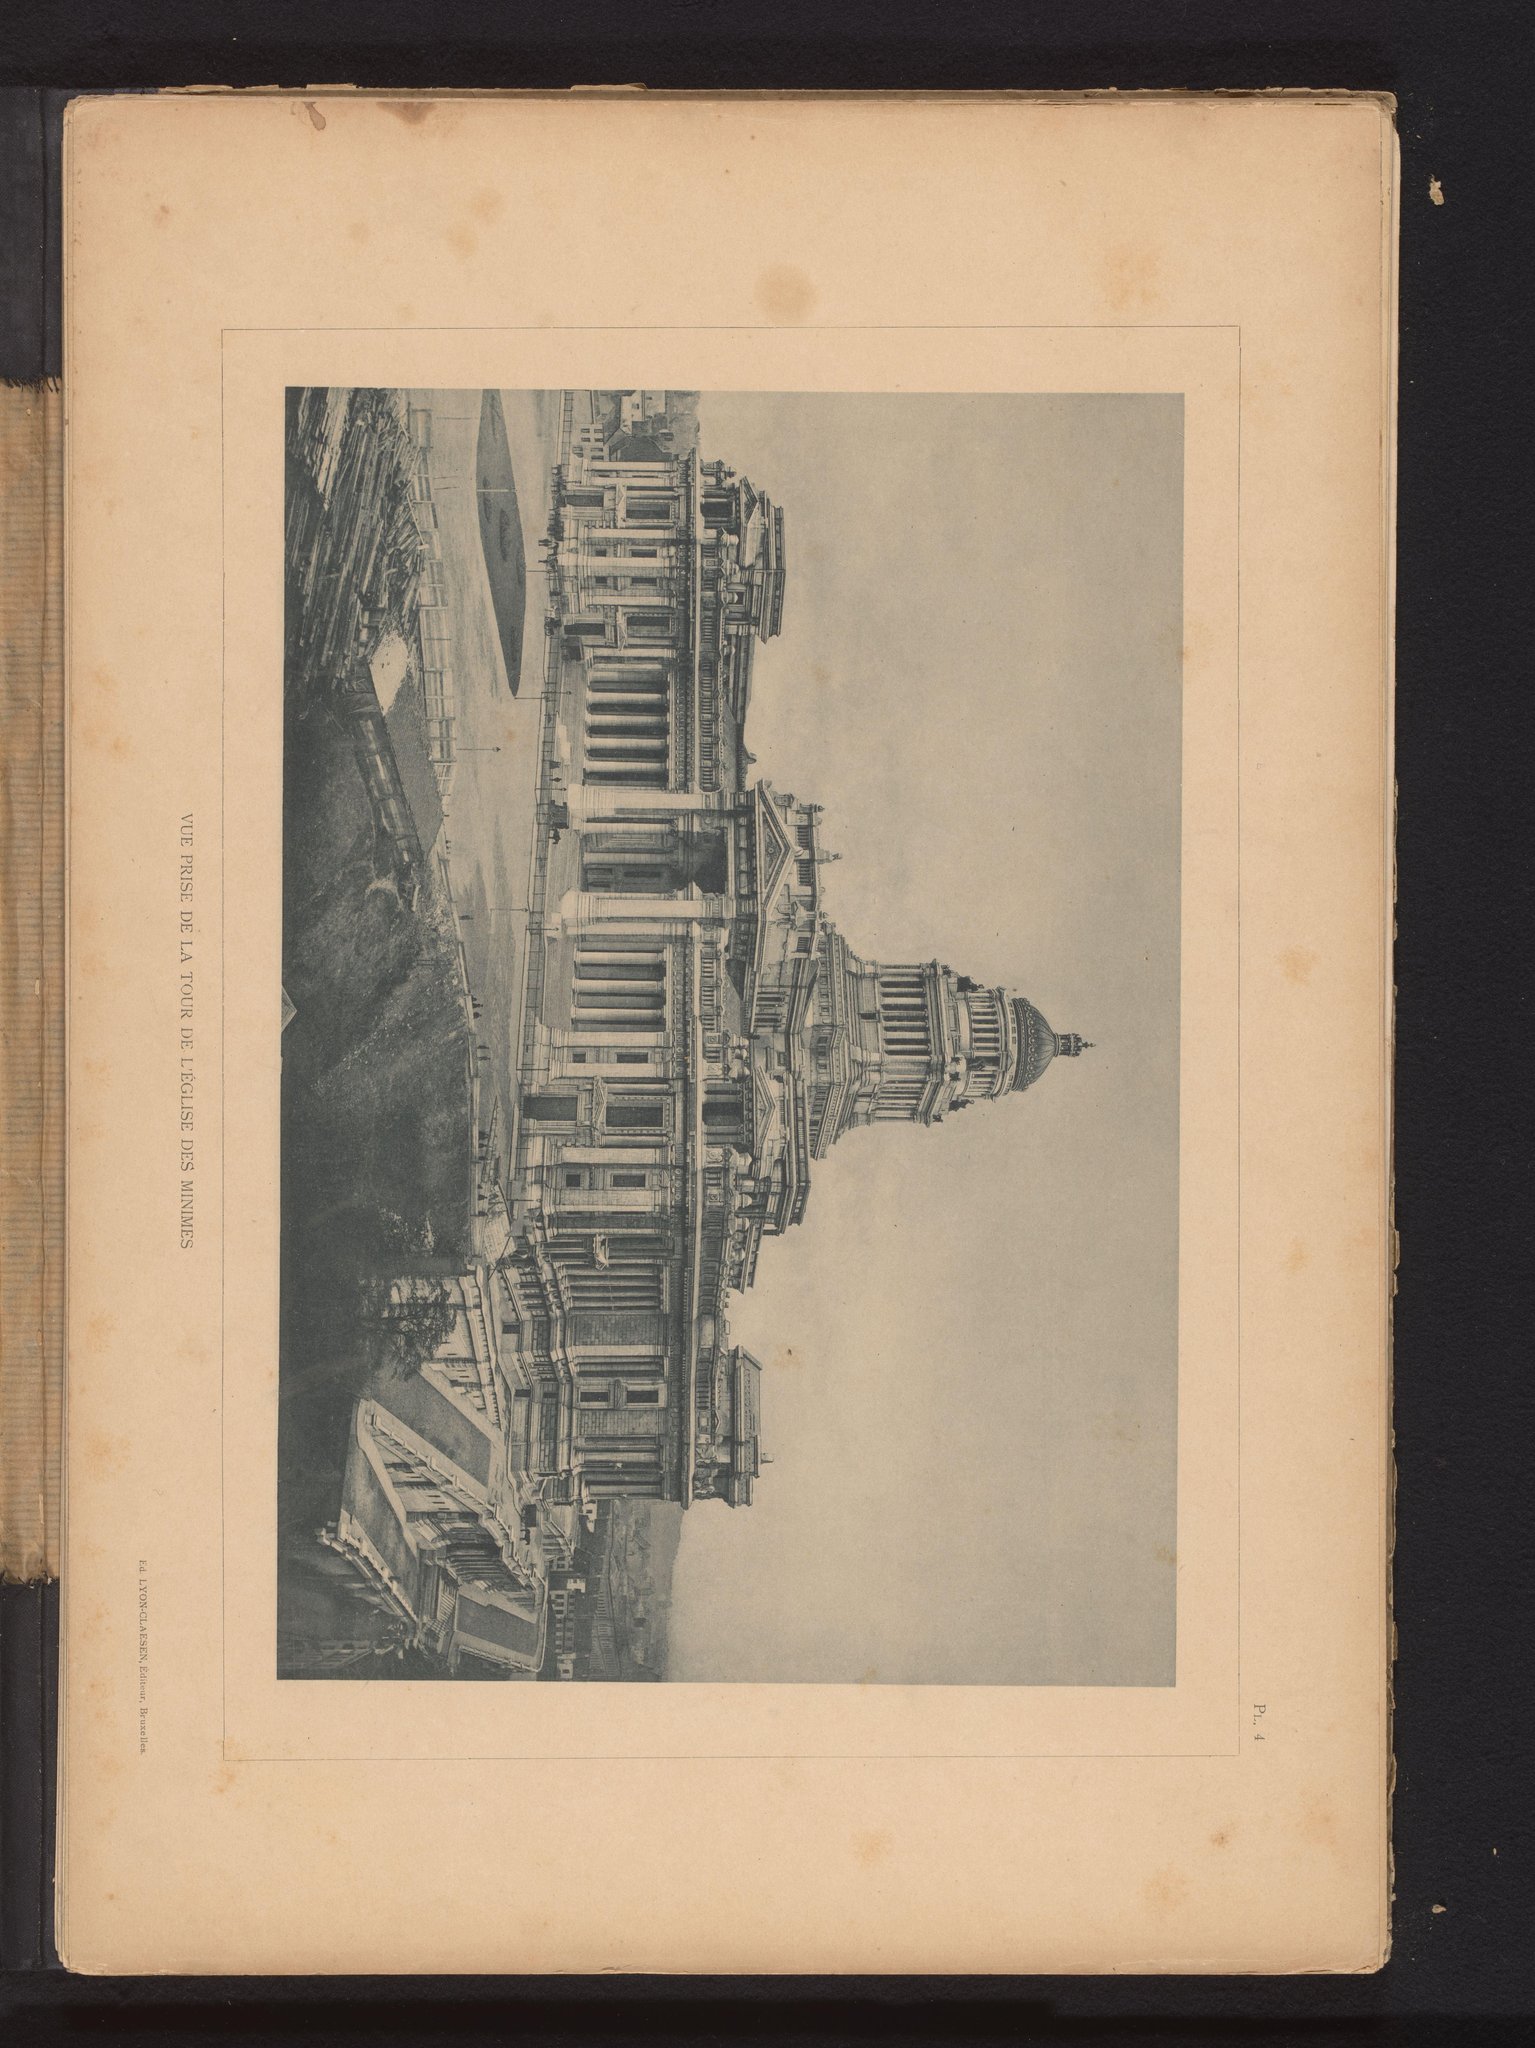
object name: photomechanical print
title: Vue Prise de la Tour de l'Église des Minimes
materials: paper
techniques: photograph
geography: brussels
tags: court building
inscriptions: number: ‘PL. 4’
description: Deze prent maakt deel uit van een omslag met 30 prenten op 28 bladen en een titelblad.